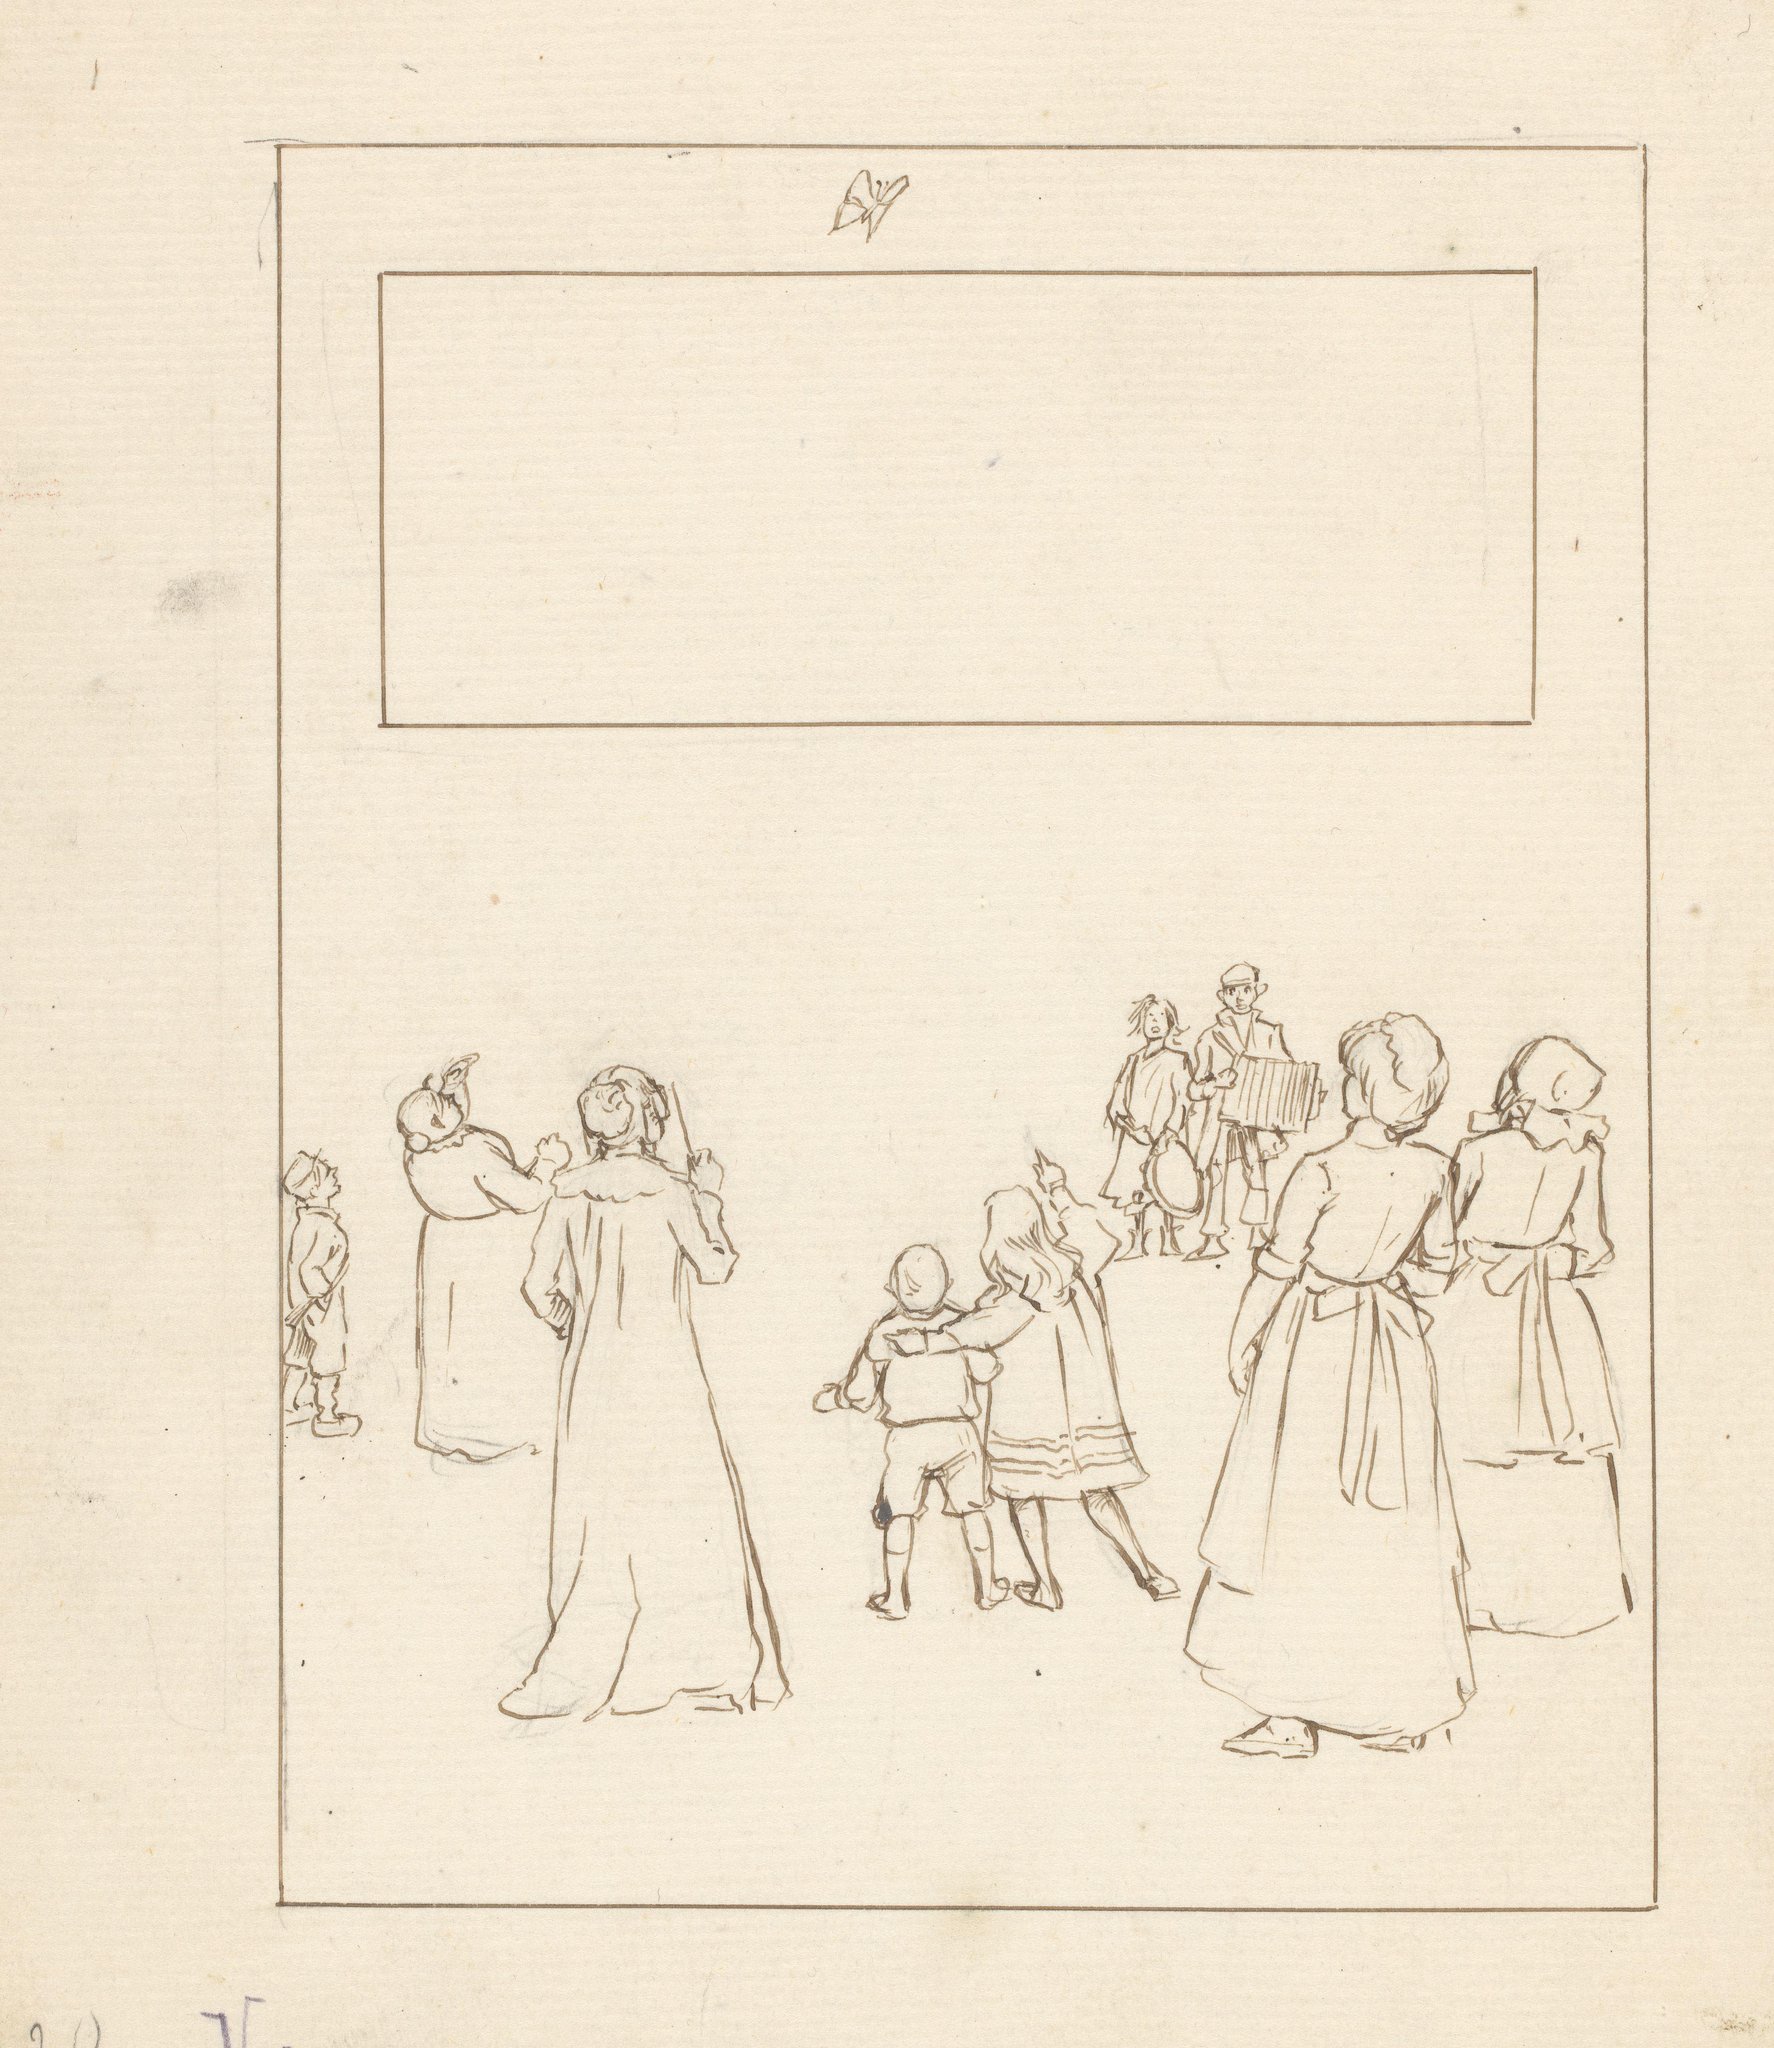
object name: boekillustratie ontwerp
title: Gezelschap voor twee musicerende kinderen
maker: Anonymous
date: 1880-1910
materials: ink, paper, pencil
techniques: pen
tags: accordion (+ artist at work), tambourine (+ artist at work), the audience ~ art performance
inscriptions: number: ‘20 V.’, collector's mark: Lugt 2228a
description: Een groep van vier vrouwen, twee jongens en een meisje staat voor een jongen met een accordeon en een meisje met een tamboerijn.